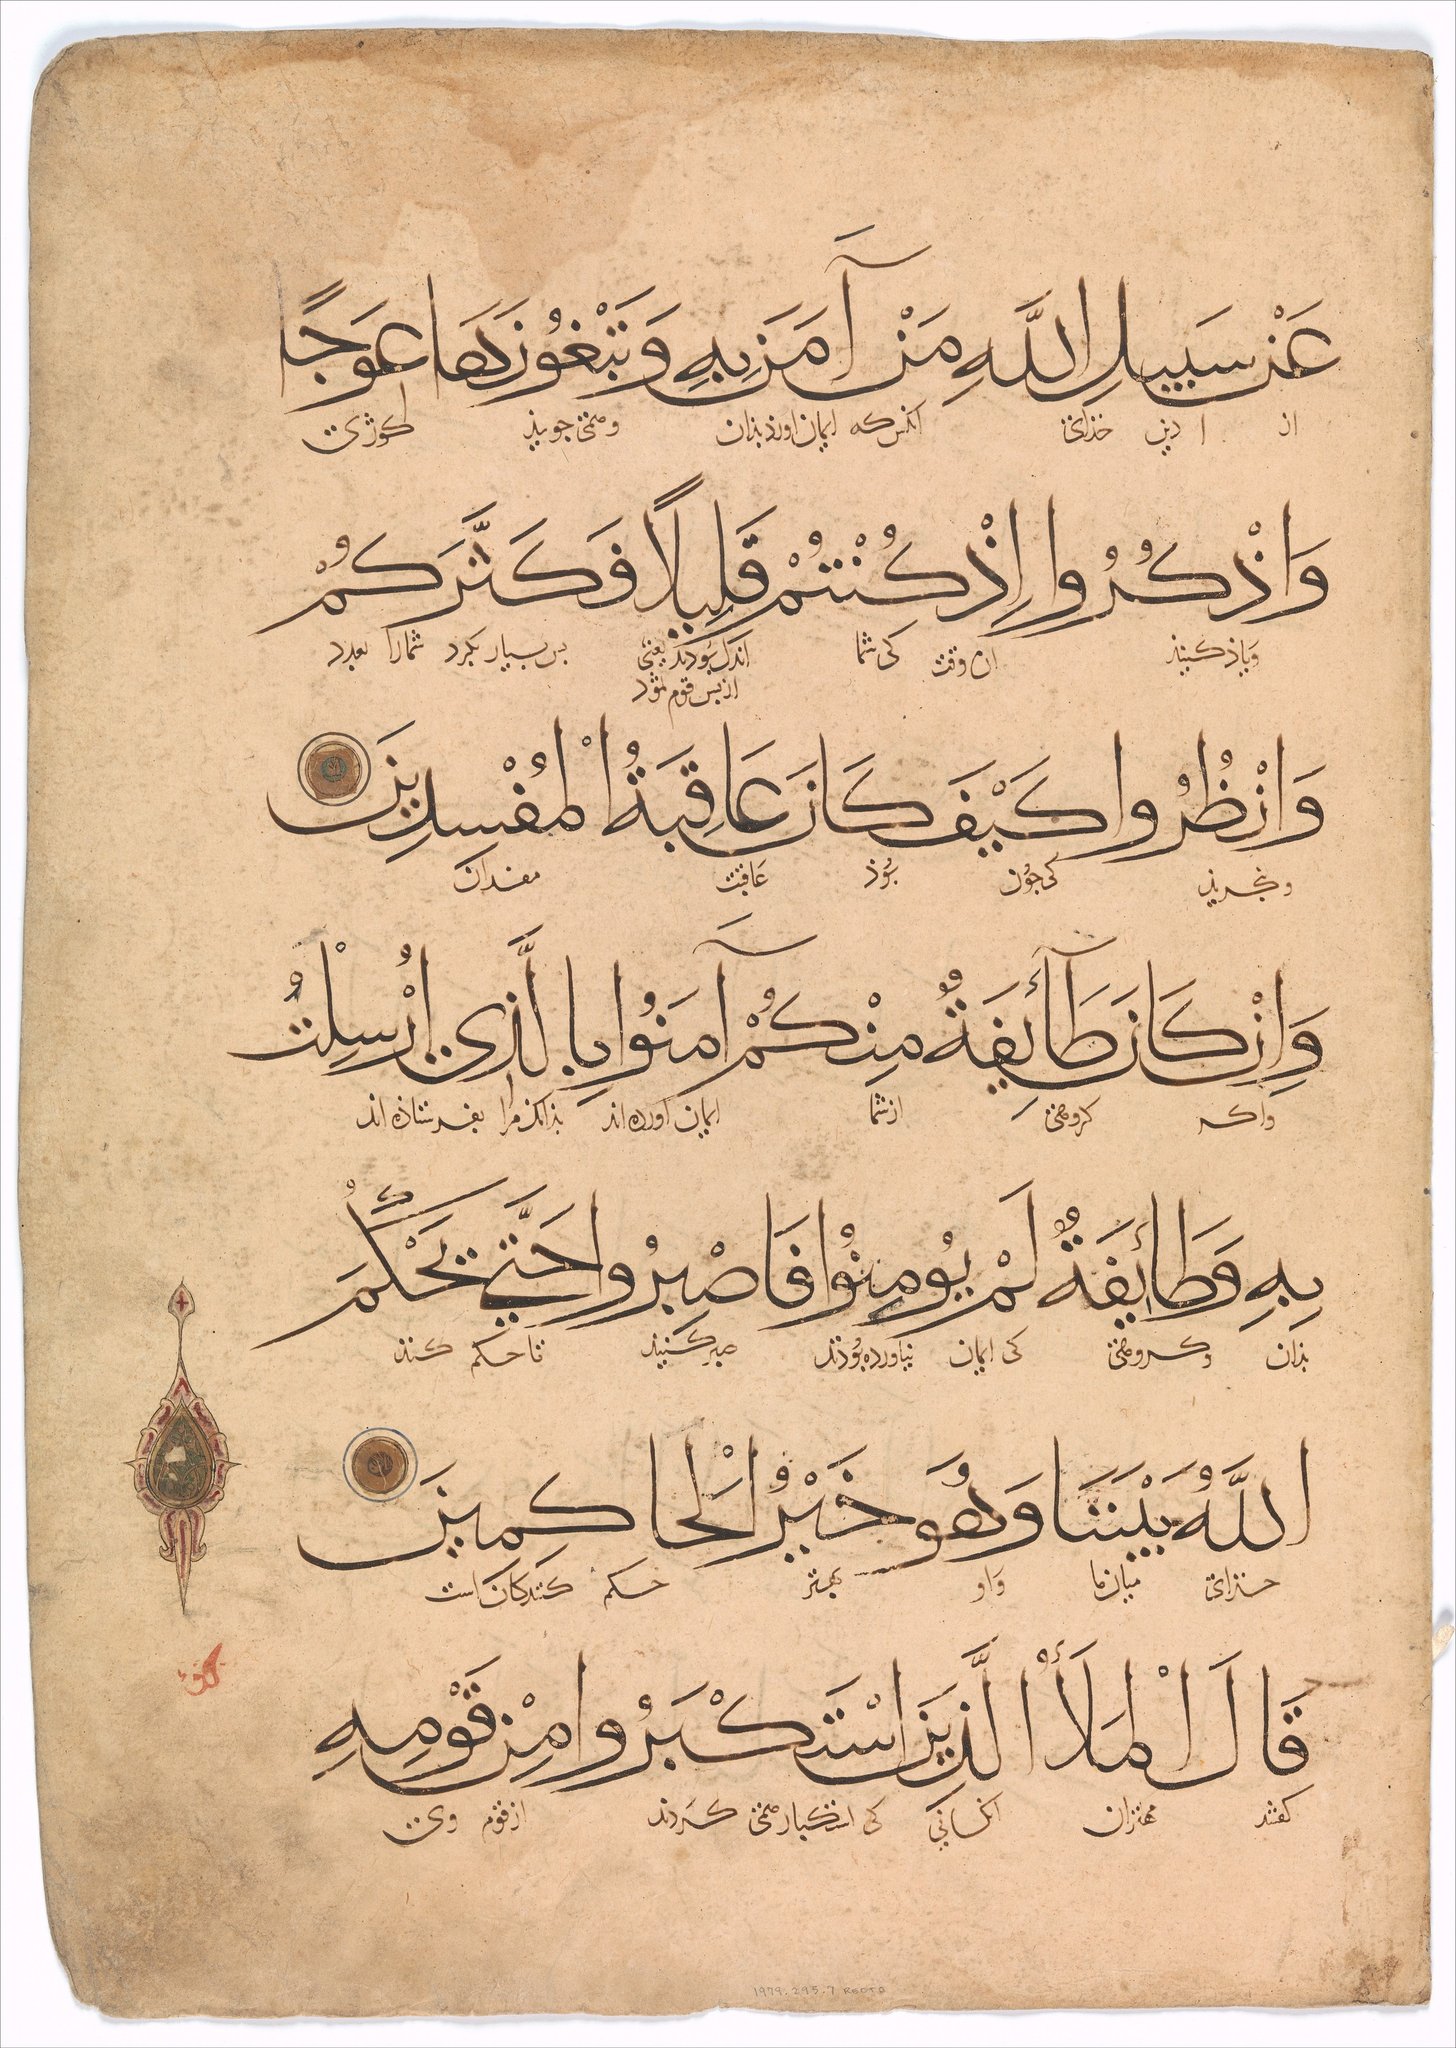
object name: folio from a non illustrated manuscript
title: Folio from a Qur'an Manuscript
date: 1301-1400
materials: gold, ink, paper, watercolor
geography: india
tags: qur'an